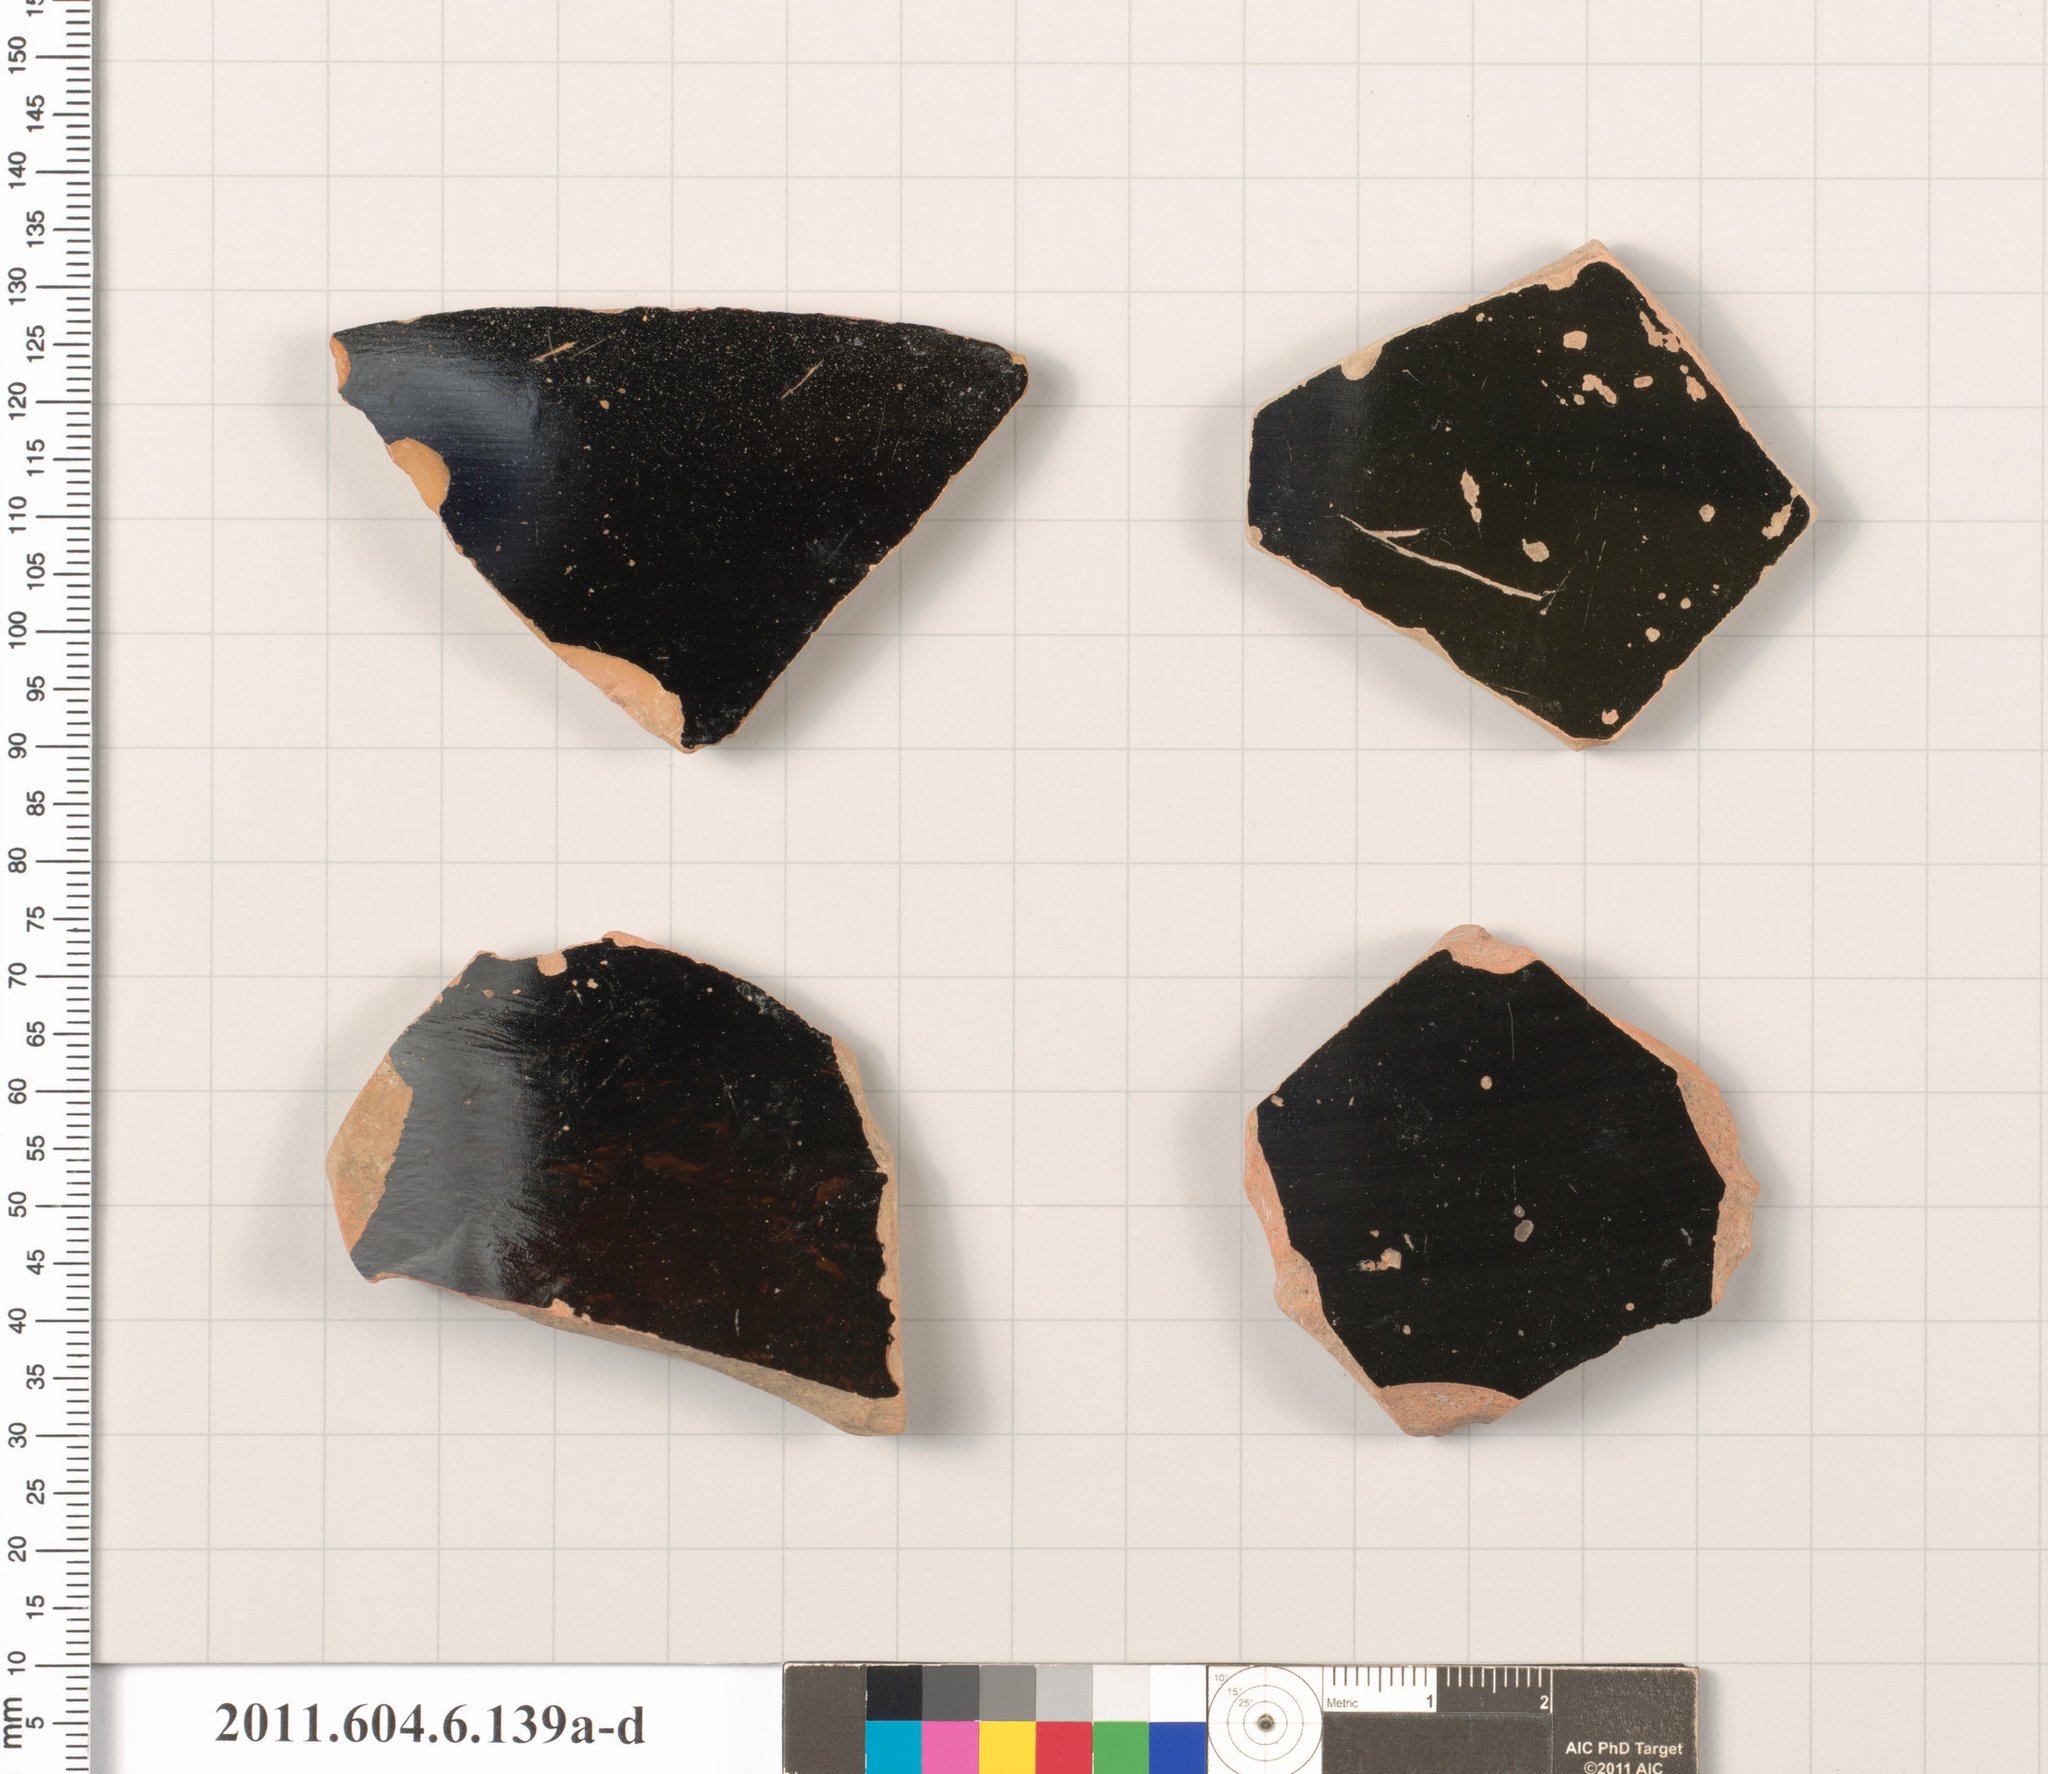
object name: undetermined open shape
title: Terracotta fragments of open shapes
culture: greek, attic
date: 600-401 BCE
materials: terracotta